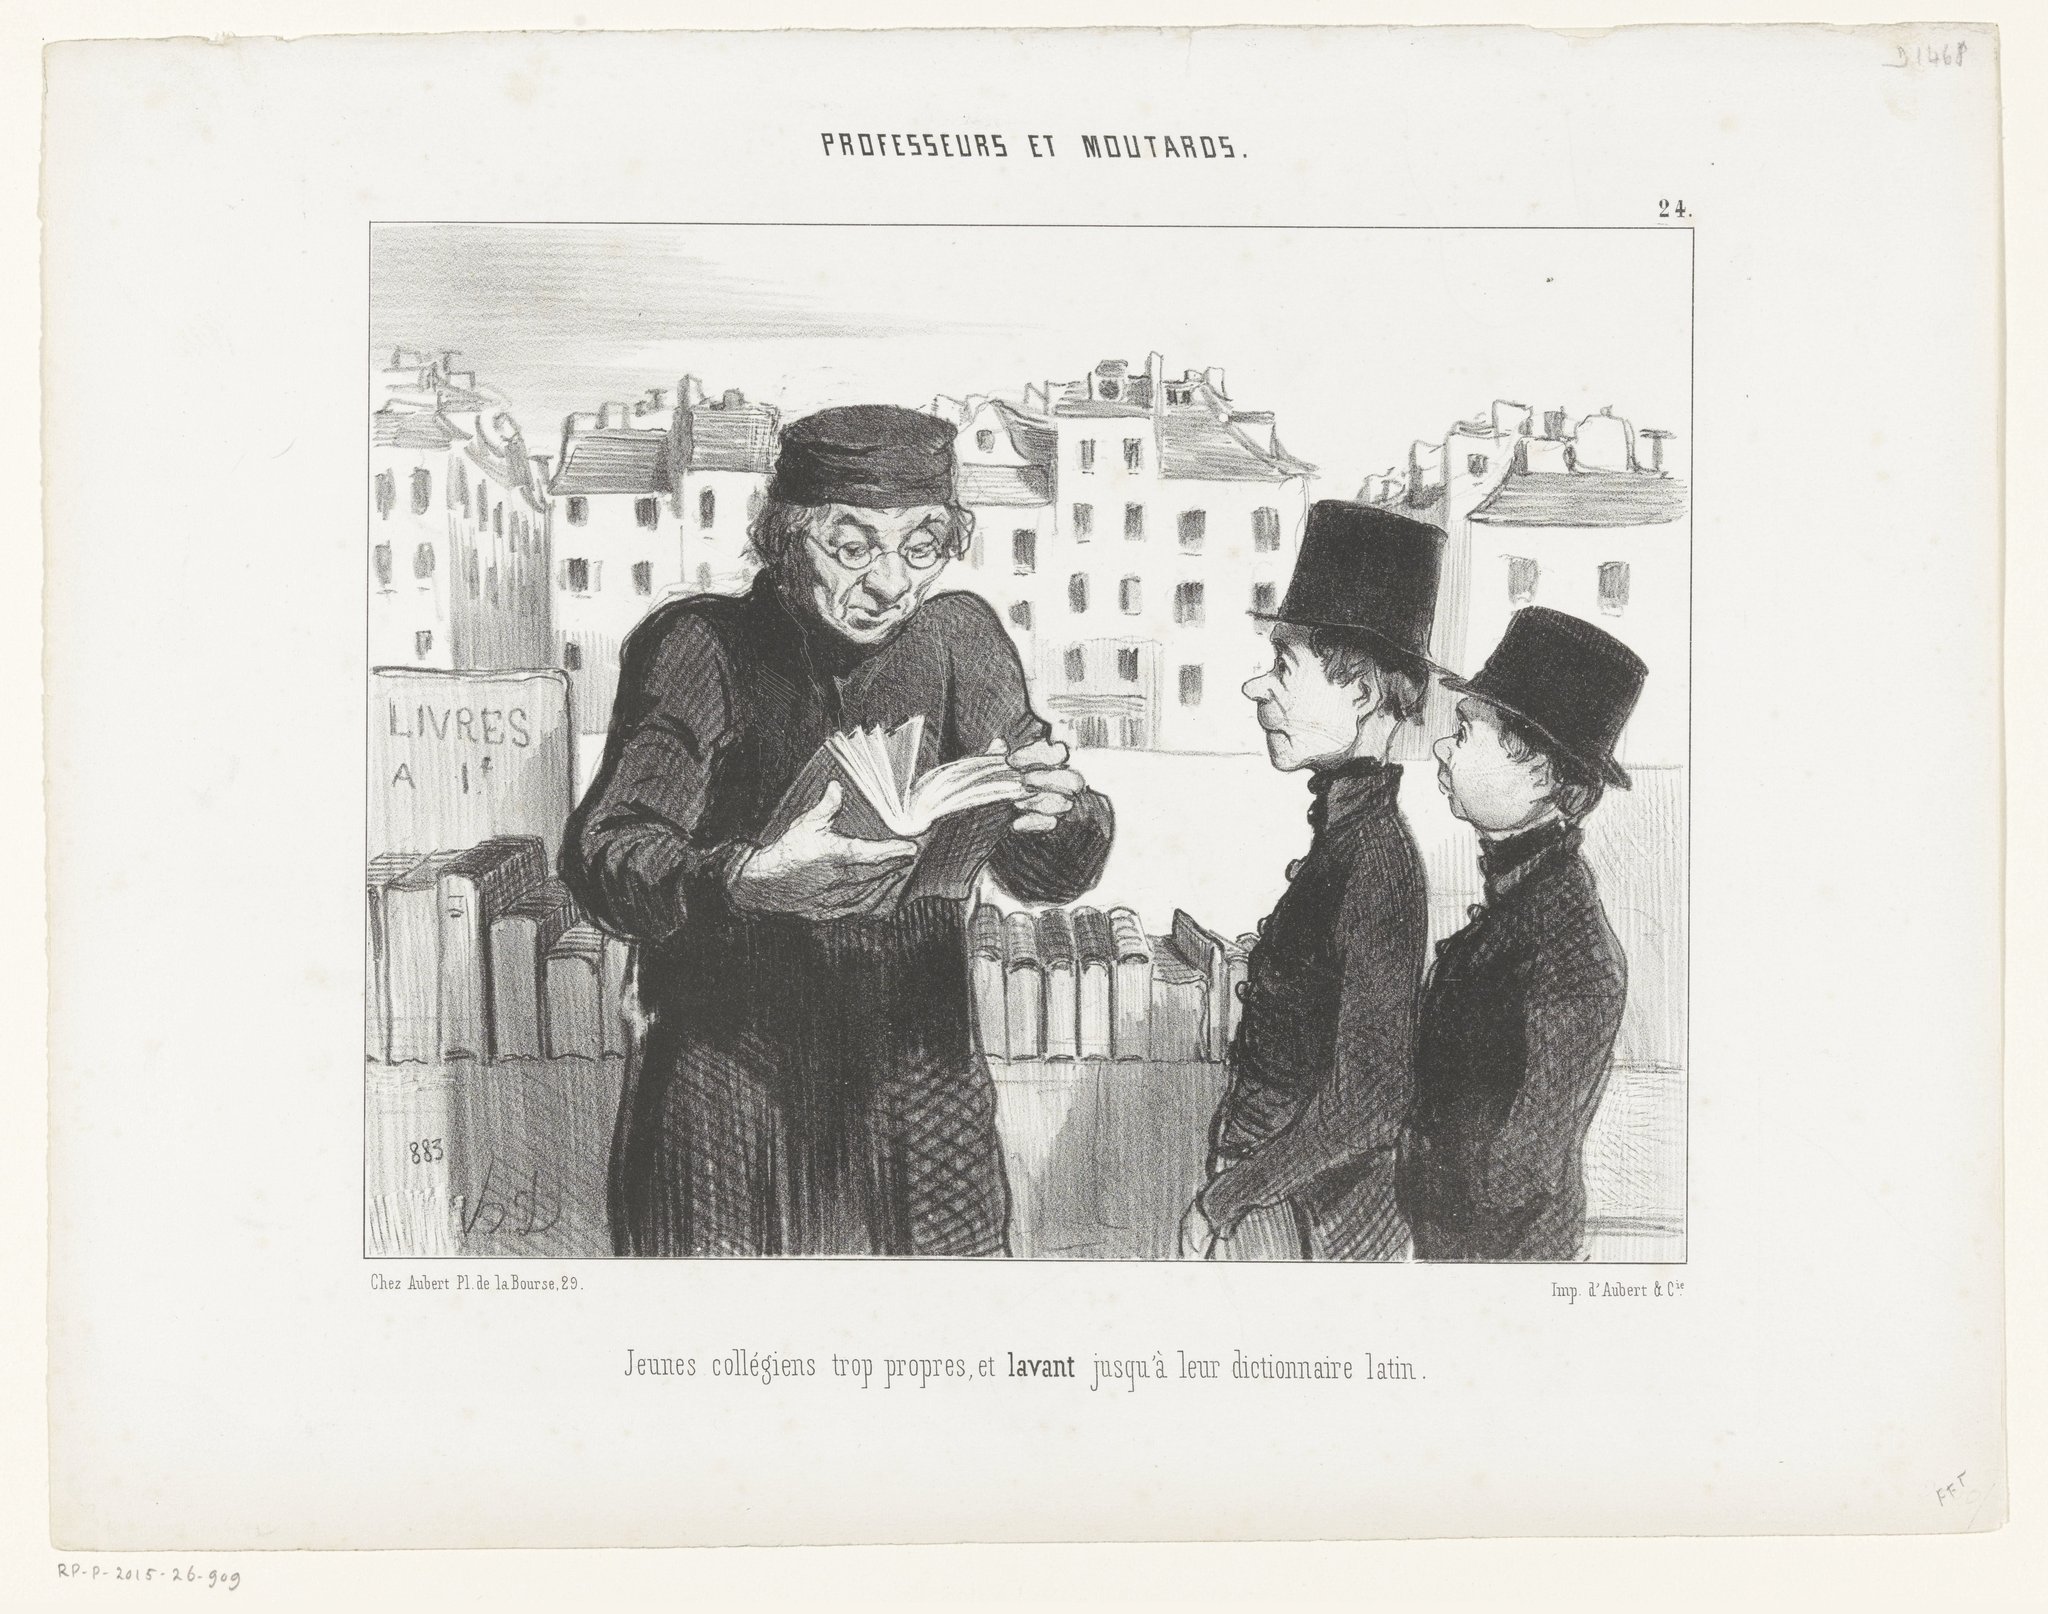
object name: print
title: Professeurs et moutards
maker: honoré daumier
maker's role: draughtsman, painter, print maker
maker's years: 1808-1879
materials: paper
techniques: lithograph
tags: book-stall, kiosk, book, street-trader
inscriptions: collector's mark: Lugt 4779, collector's mark: Lugt 2228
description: De boekhandelaar bladert door het aangeboden boek, achter hem zijn voorraad uitgestald op een kade.